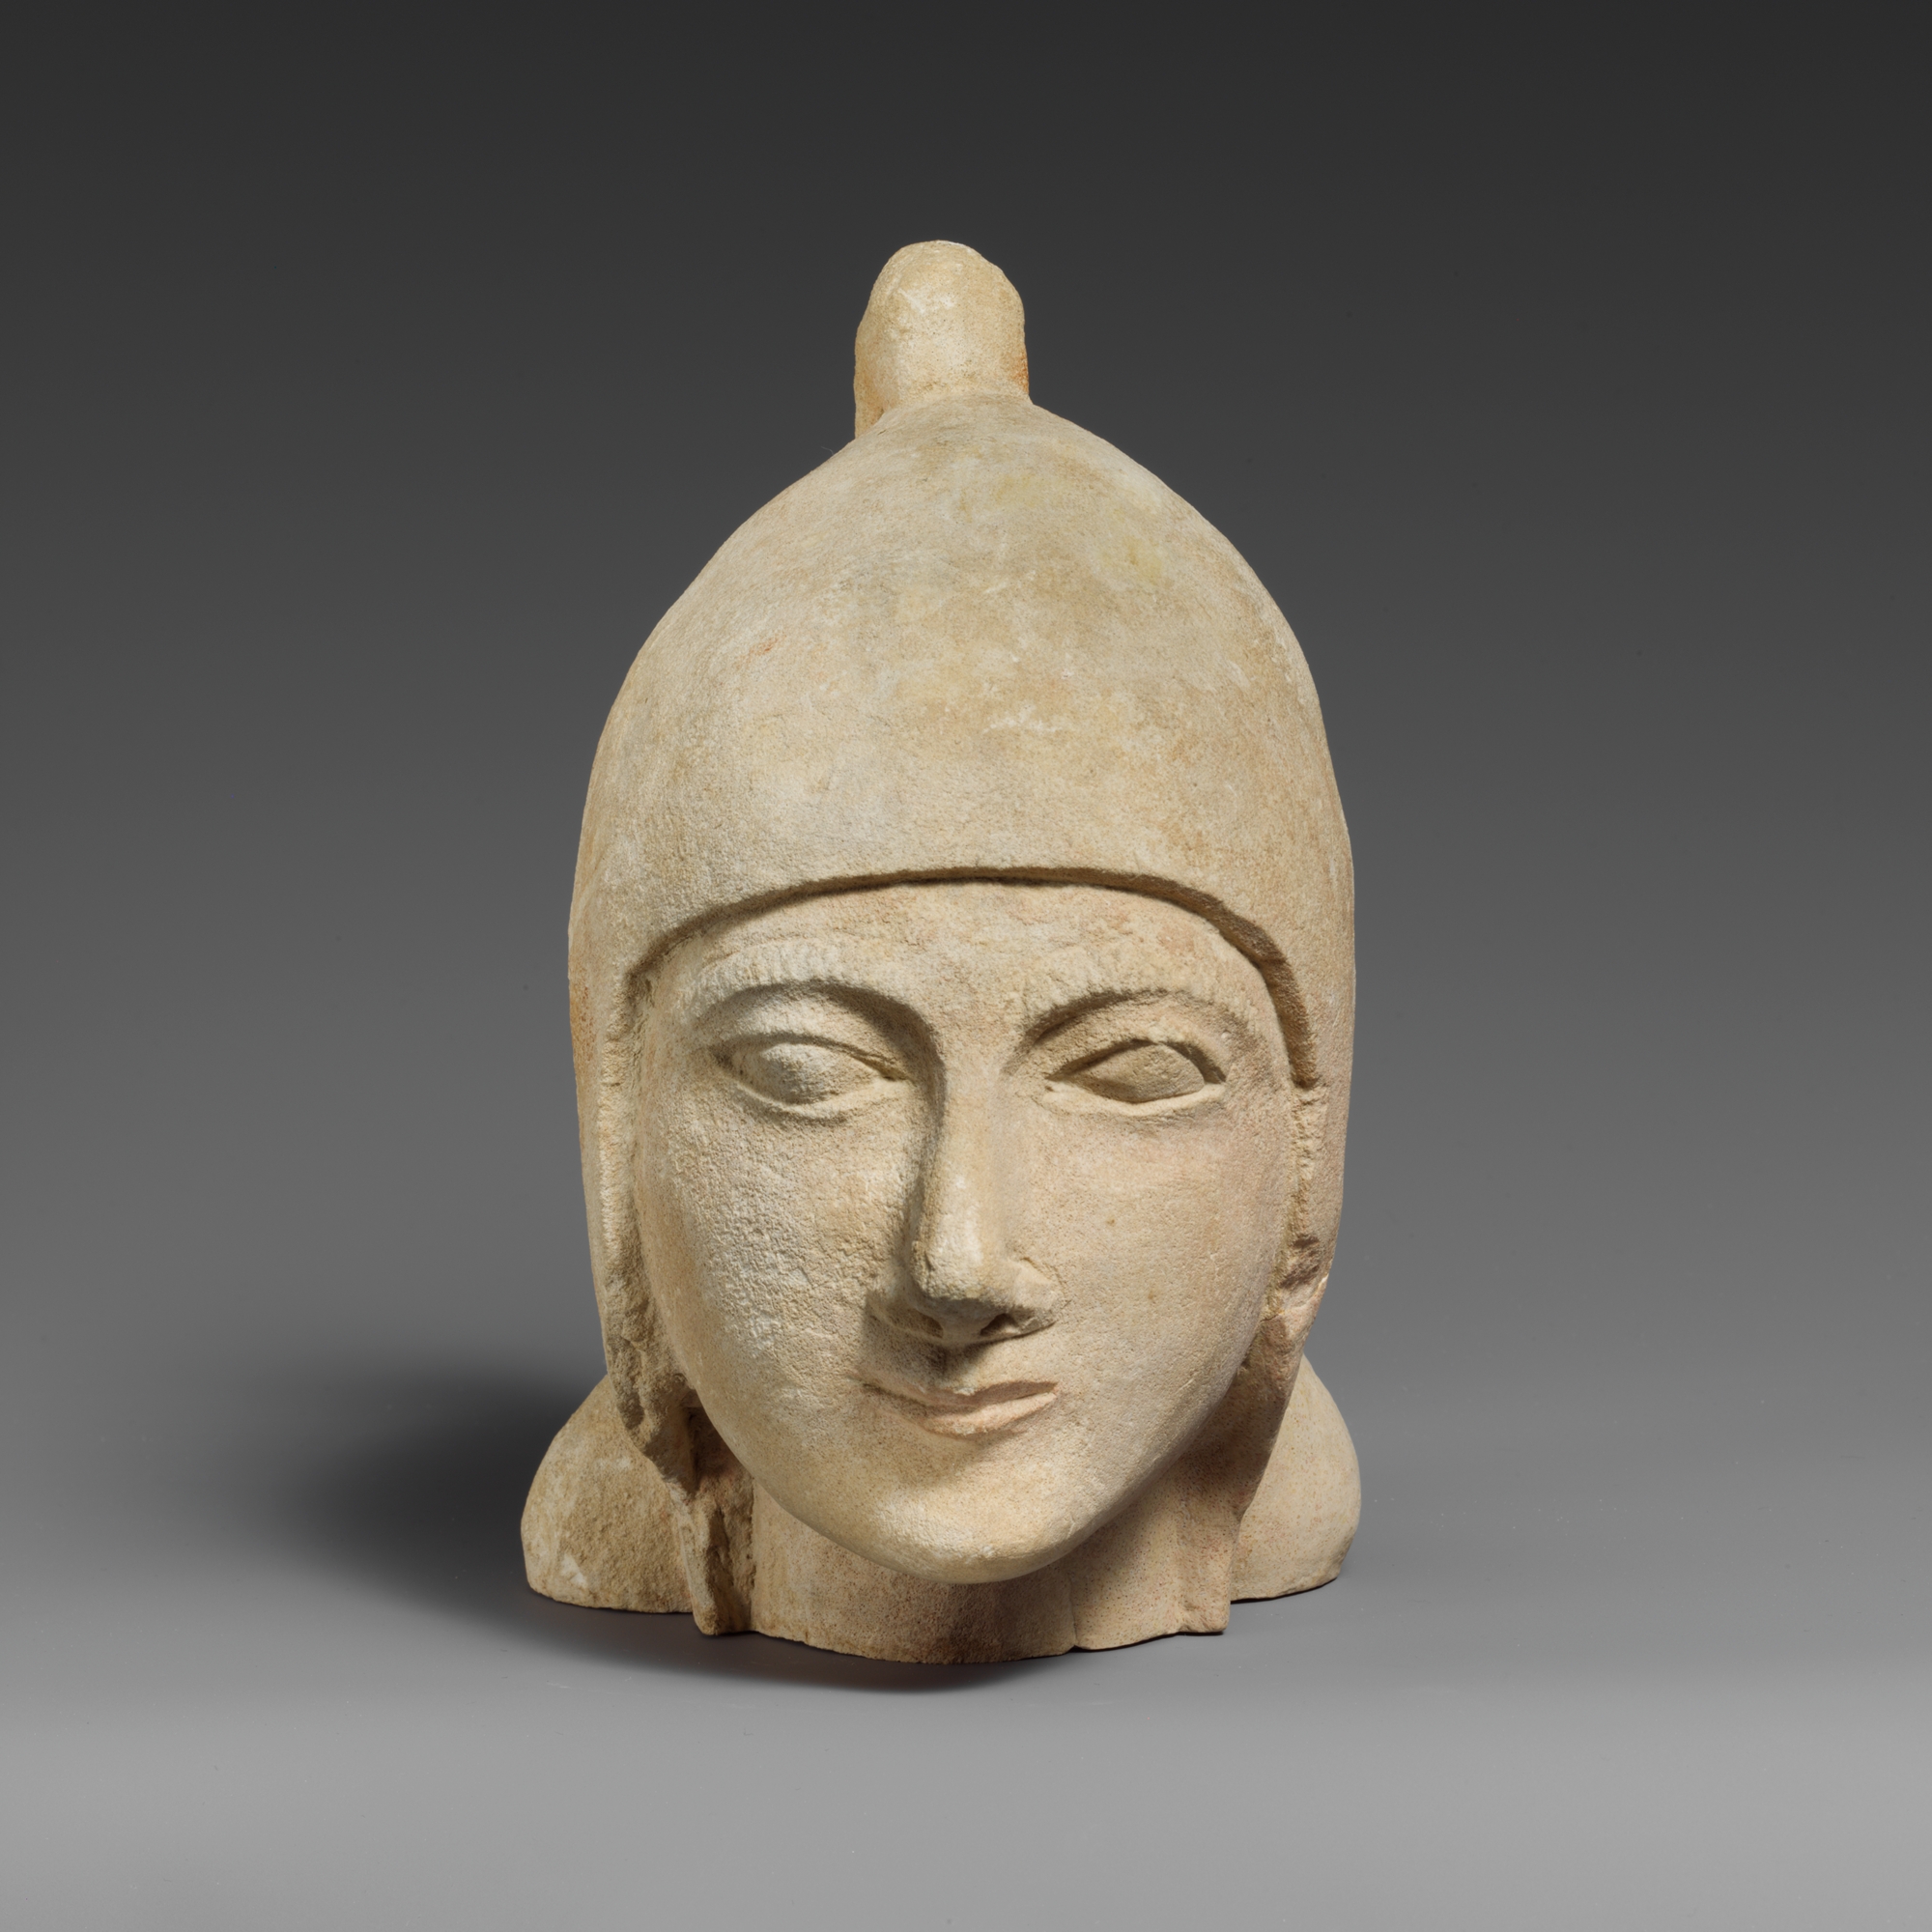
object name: head of a votary in assyrian cap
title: Limestone head of a beardless male wearing a conical helmet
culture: cypriot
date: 600-551 BCE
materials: limestone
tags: helmets,heads,men